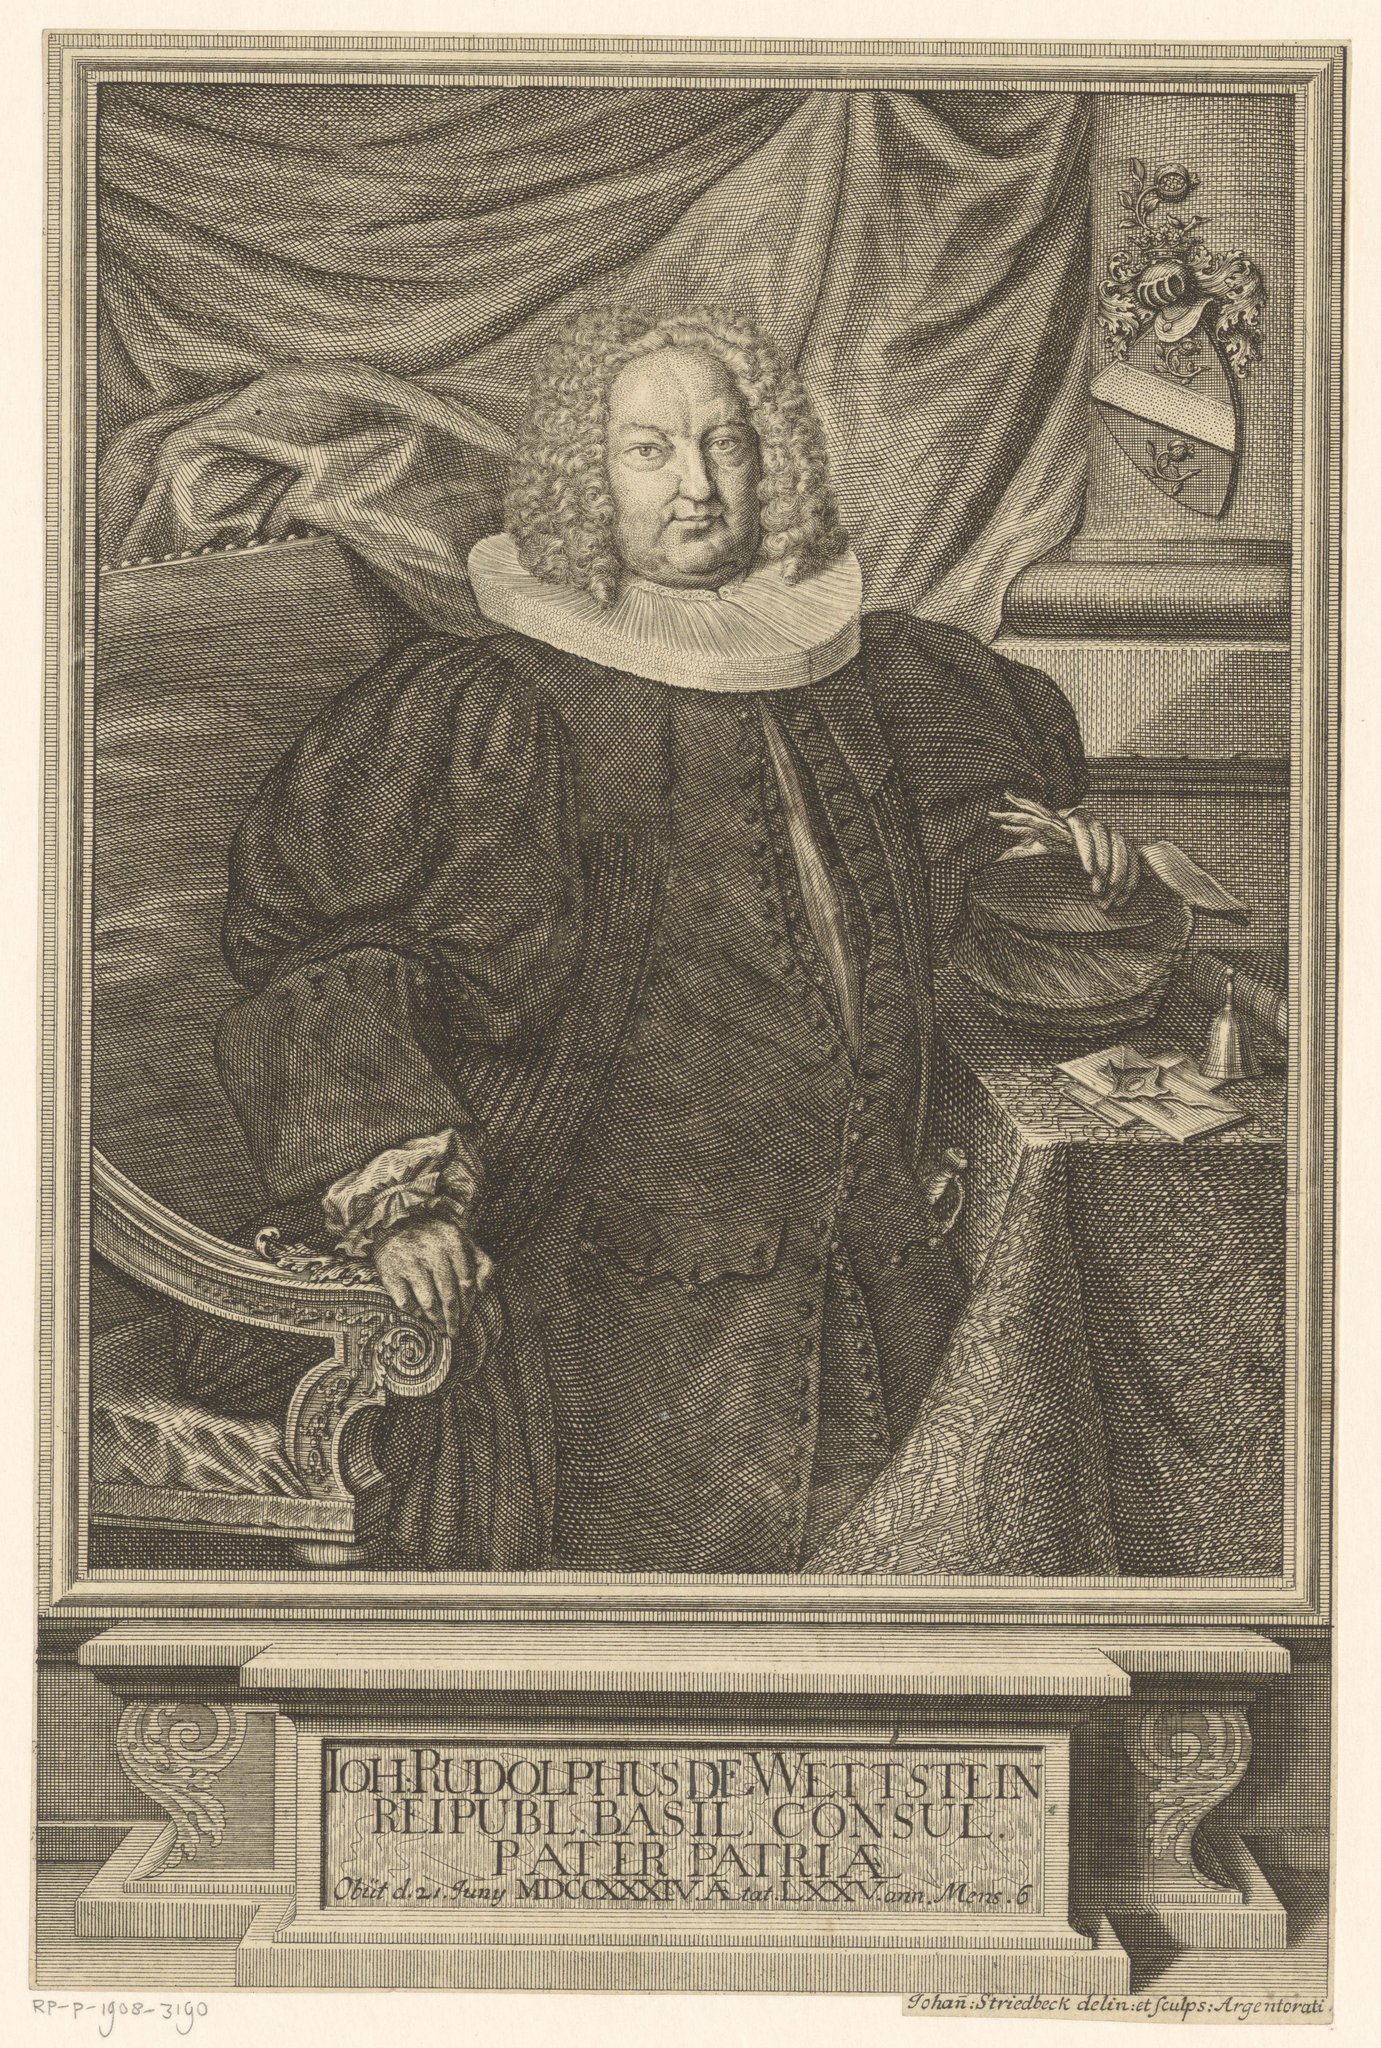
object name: print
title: Portret van Johann Rudolf Wettstein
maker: johann stridbeck (iii)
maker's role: print maker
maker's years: 1707-1772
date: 1734-1772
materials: paper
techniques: engraving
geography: straatsburg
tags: mayor, gloves, mittens, etc., historical persons, armorial bearing, heraldry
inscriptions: collector's mark: Lugt 2228